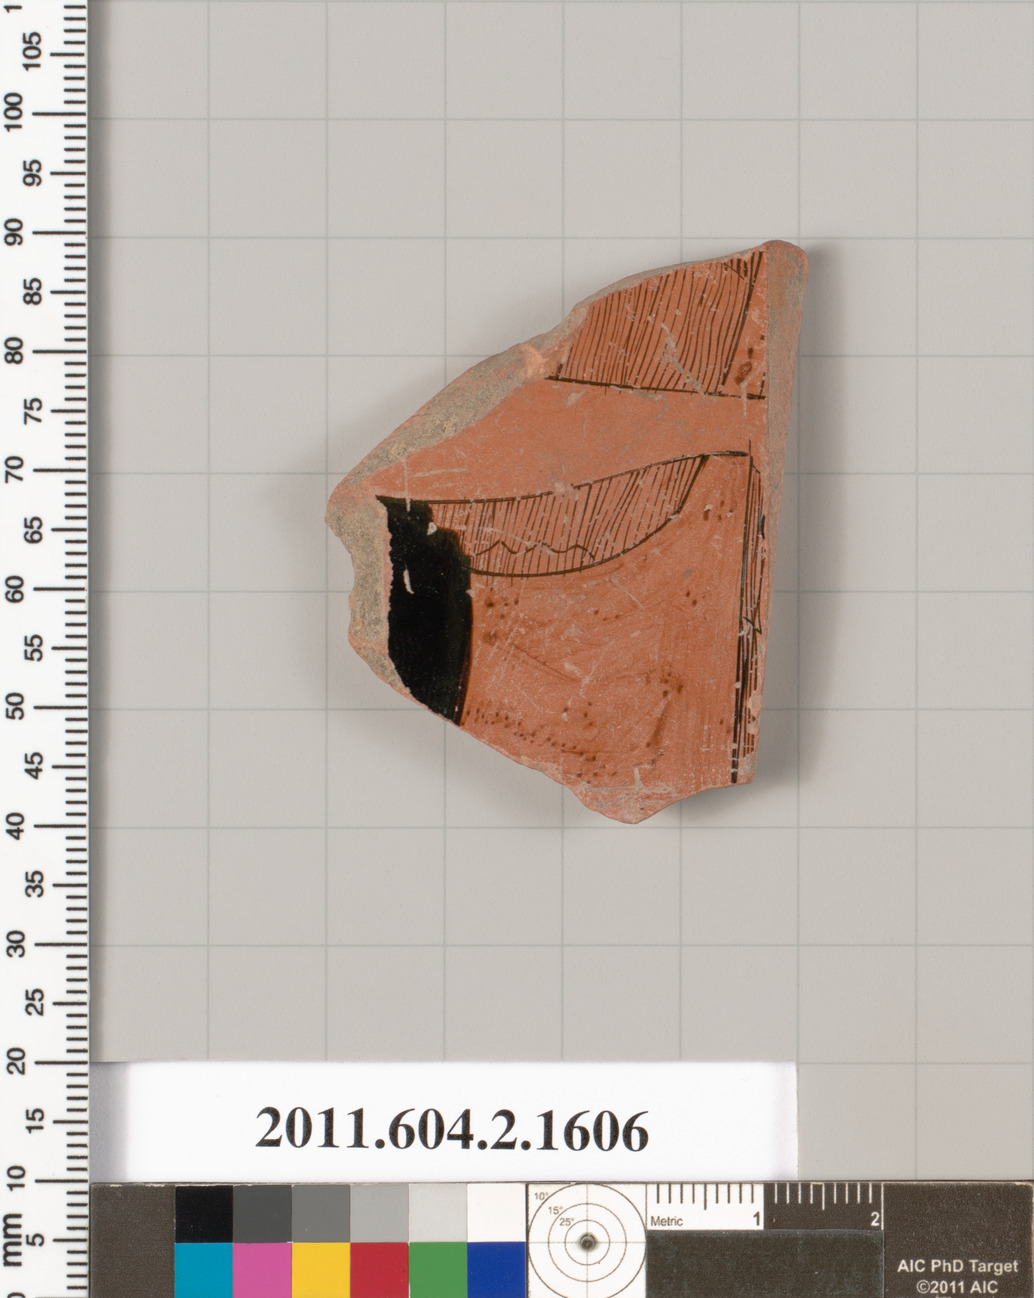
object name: bell krater fragment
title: Terracotta fragment of a bell-krater (bowl for mixing wine and water)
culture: greek, attic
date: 475-451 BCE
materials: terracotta